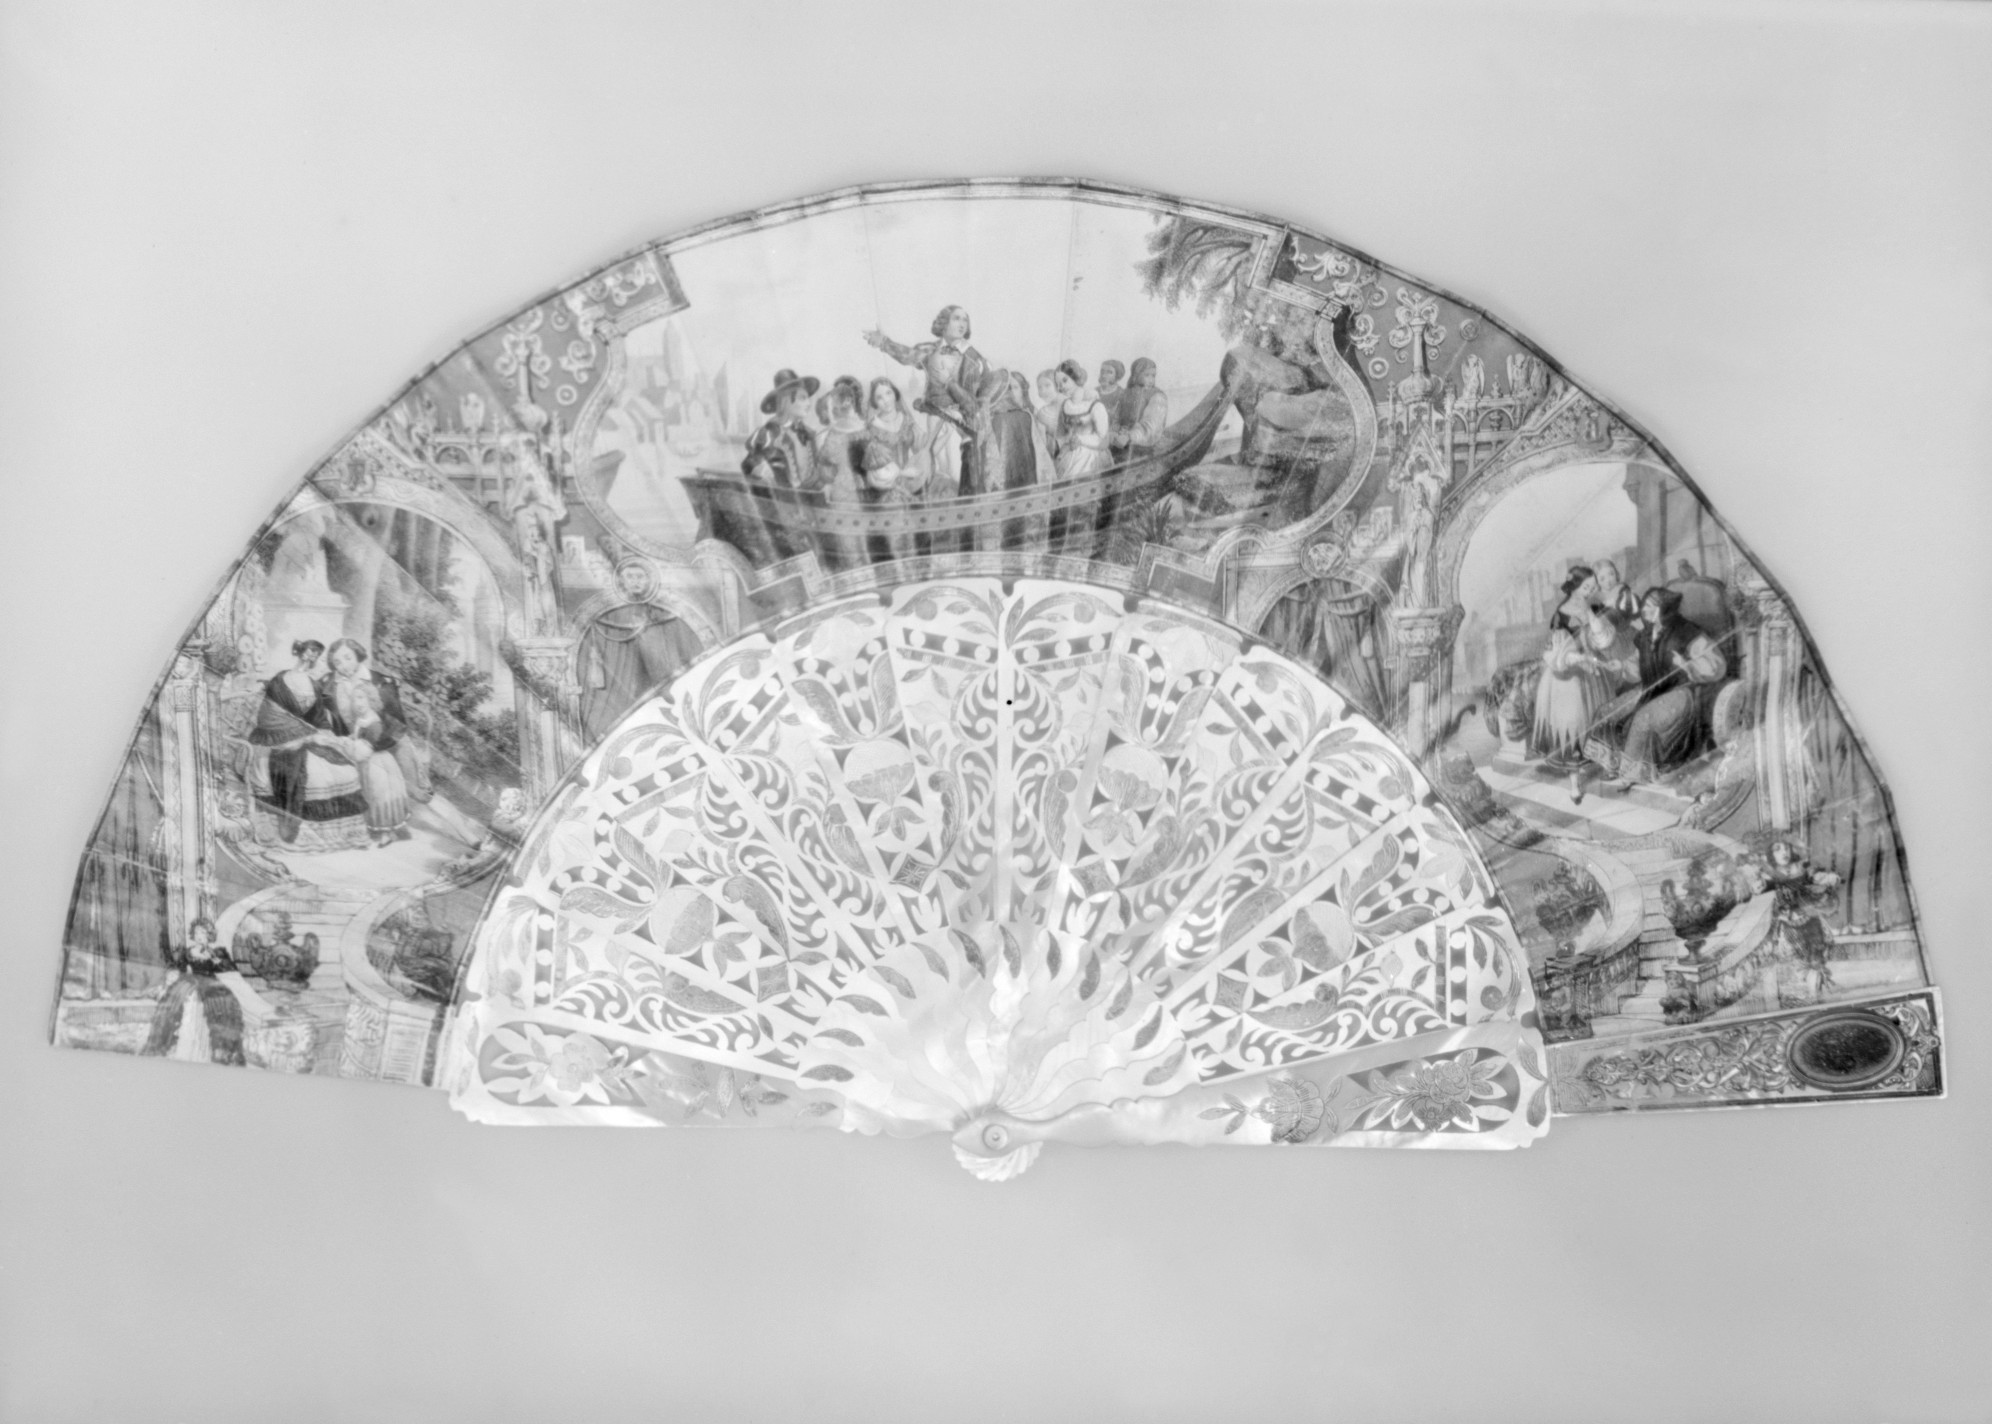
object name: fan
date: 1840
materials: copper, mother of pearl, paper, silver gilt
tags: men,women,boats